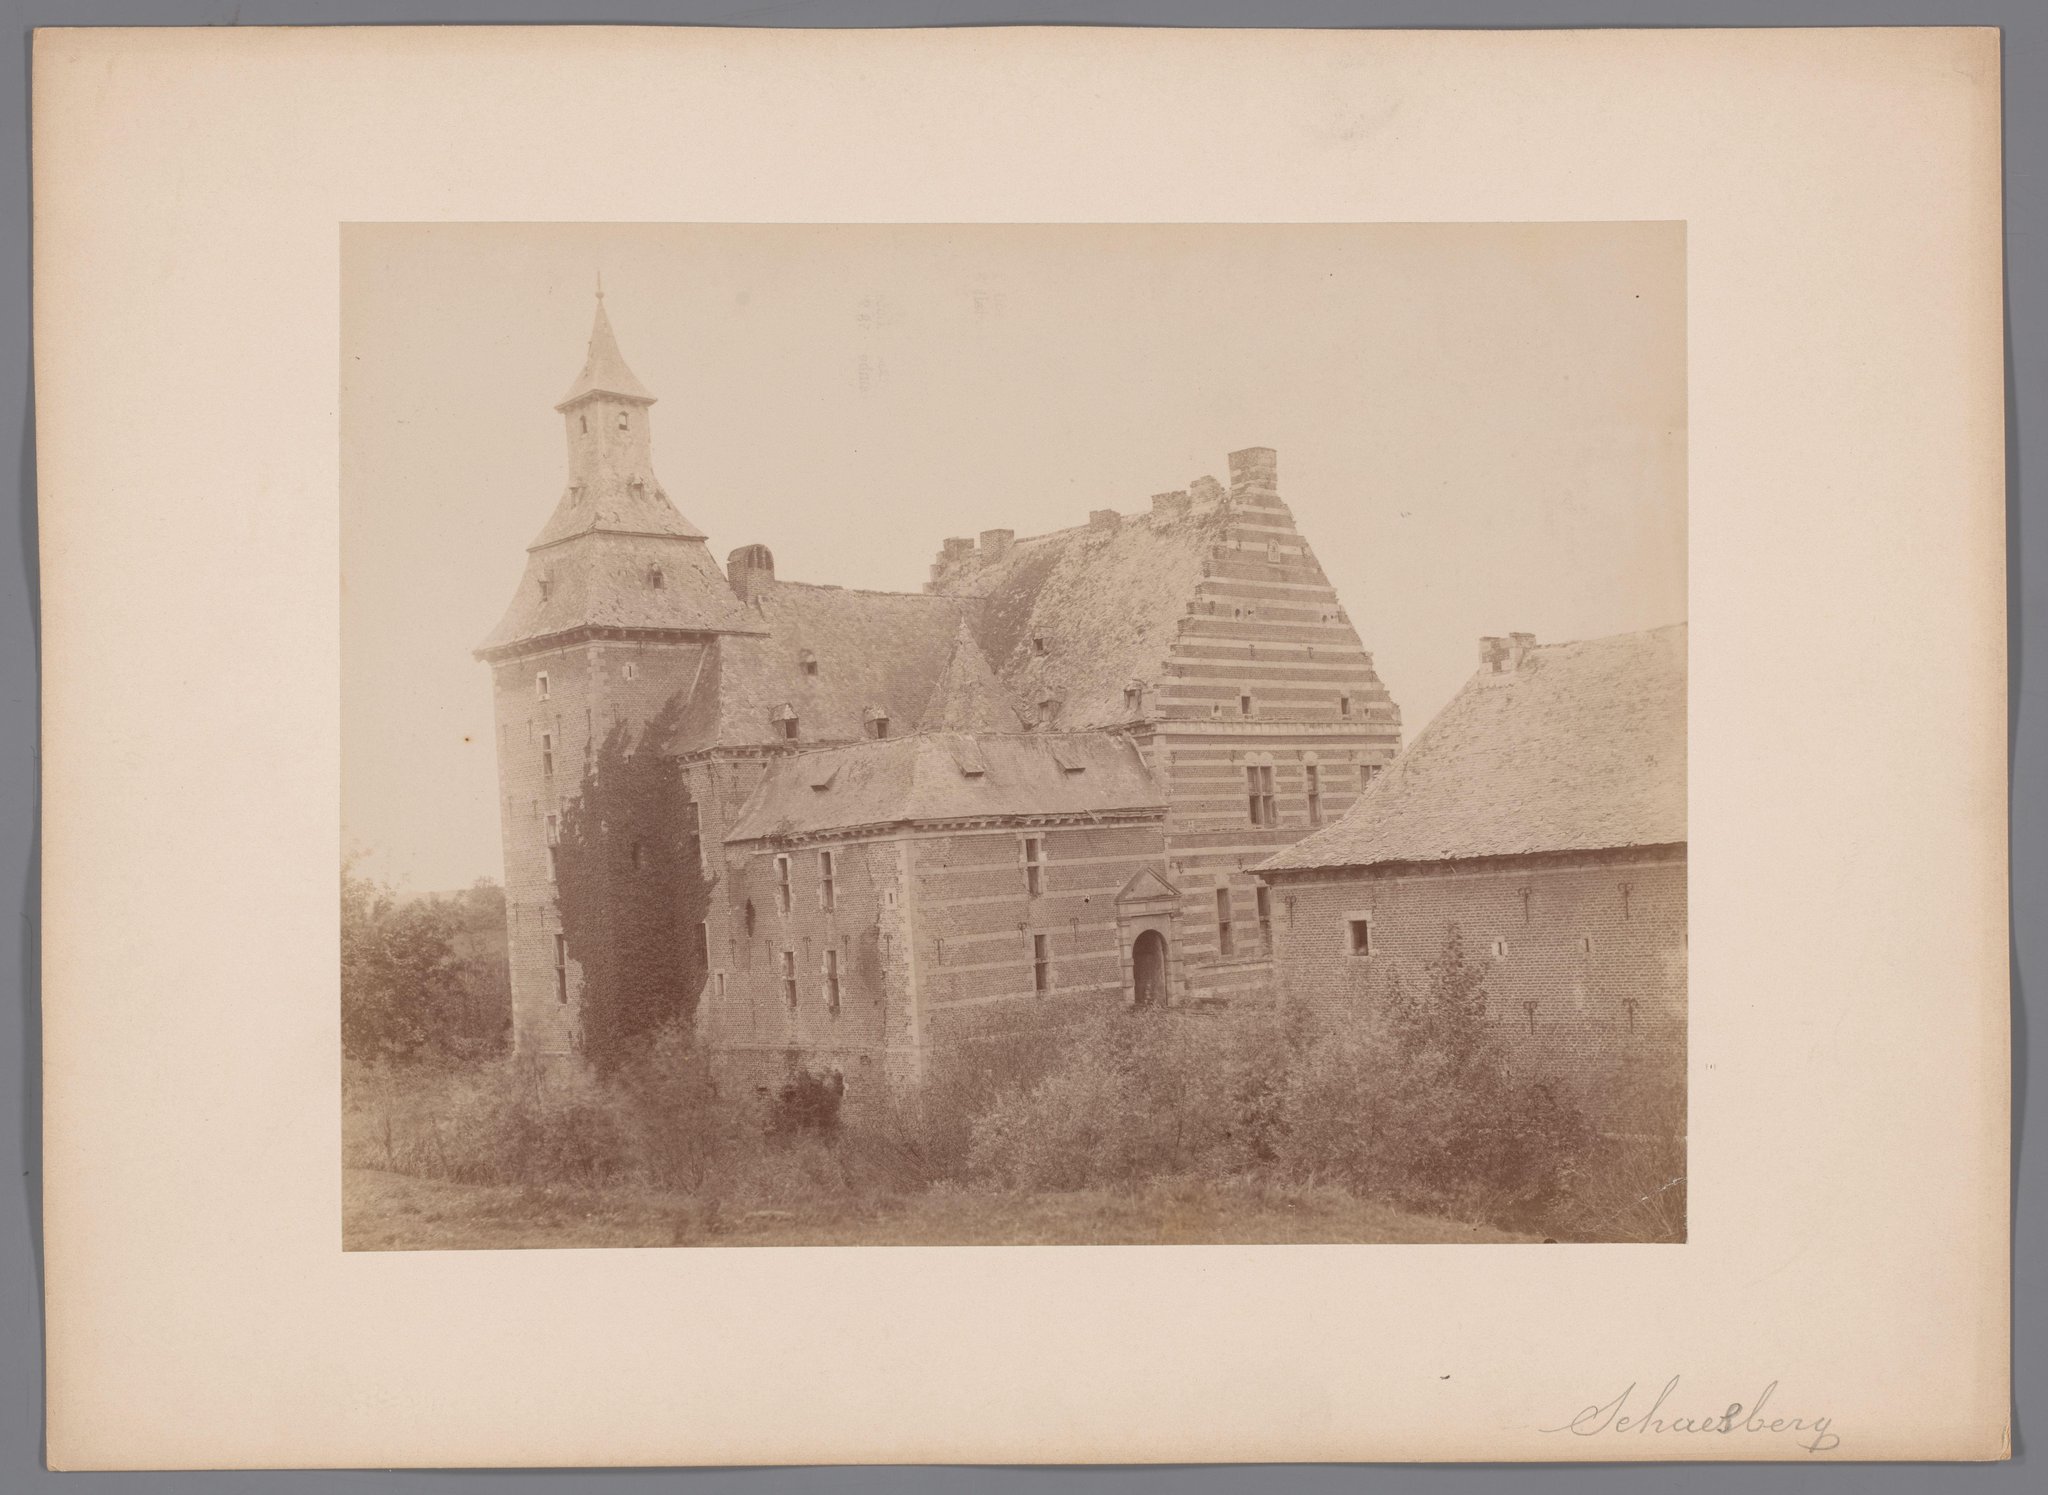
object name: photograph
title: Gezicht op Kasteel Schaesberg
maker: anoniem (monumentenzorg)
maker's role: fotograaf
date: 1890-1920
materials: cardboard, photographic support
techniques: albumen print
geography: schaesberg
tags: castle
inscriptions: annotation: ‘Schaesberg’, annotation: ‘Schaesberg (kasteel’